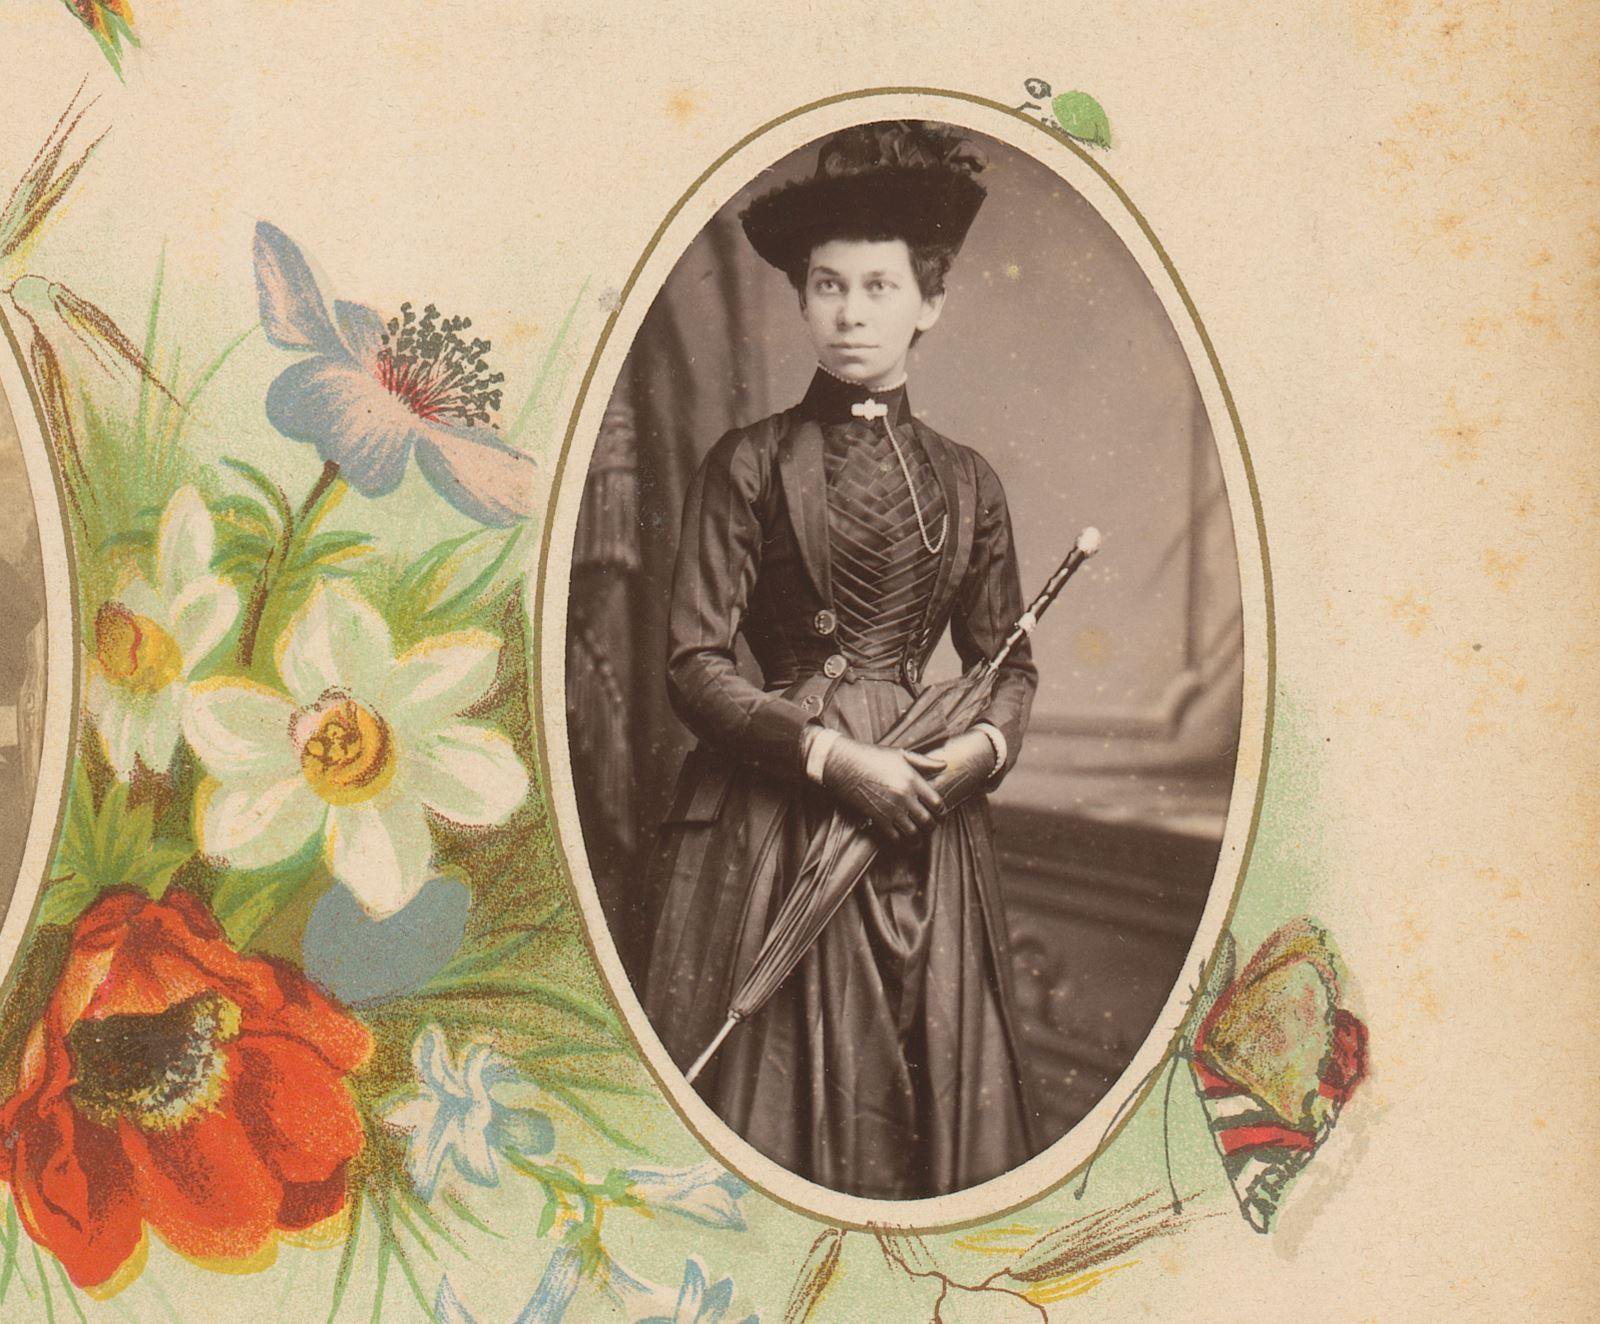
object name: photograph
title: Portret van een vrouw met hoed en paraplu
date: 1860-1900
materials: cardboard, photographic support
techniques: albumen print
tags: historical persons, head-gear: hat, umbrella, standing figure - aa - female human figure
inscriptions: inscription: ‘Artist/ Photogrphers/ Lowthian Bro/ Art Studio/ Grimsby/ (...)’